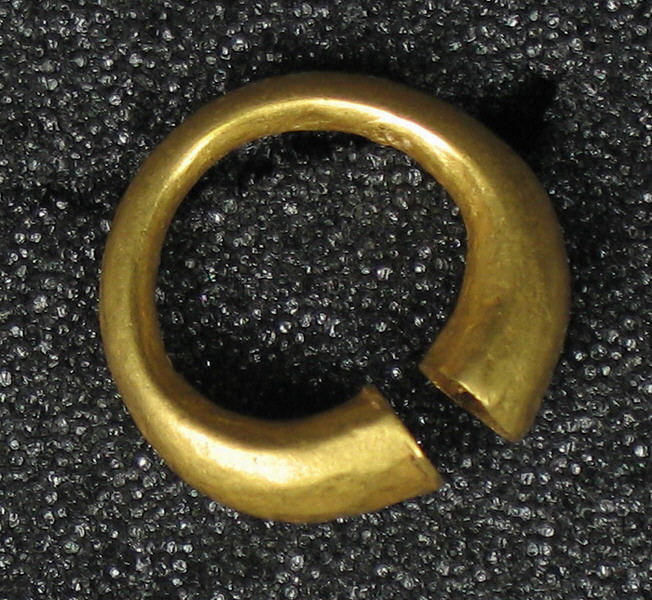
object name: pair of ear ornament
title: Pair of Ear Ornaments, Trumpet Form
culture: indonesian, central java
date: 701-1200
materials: gold